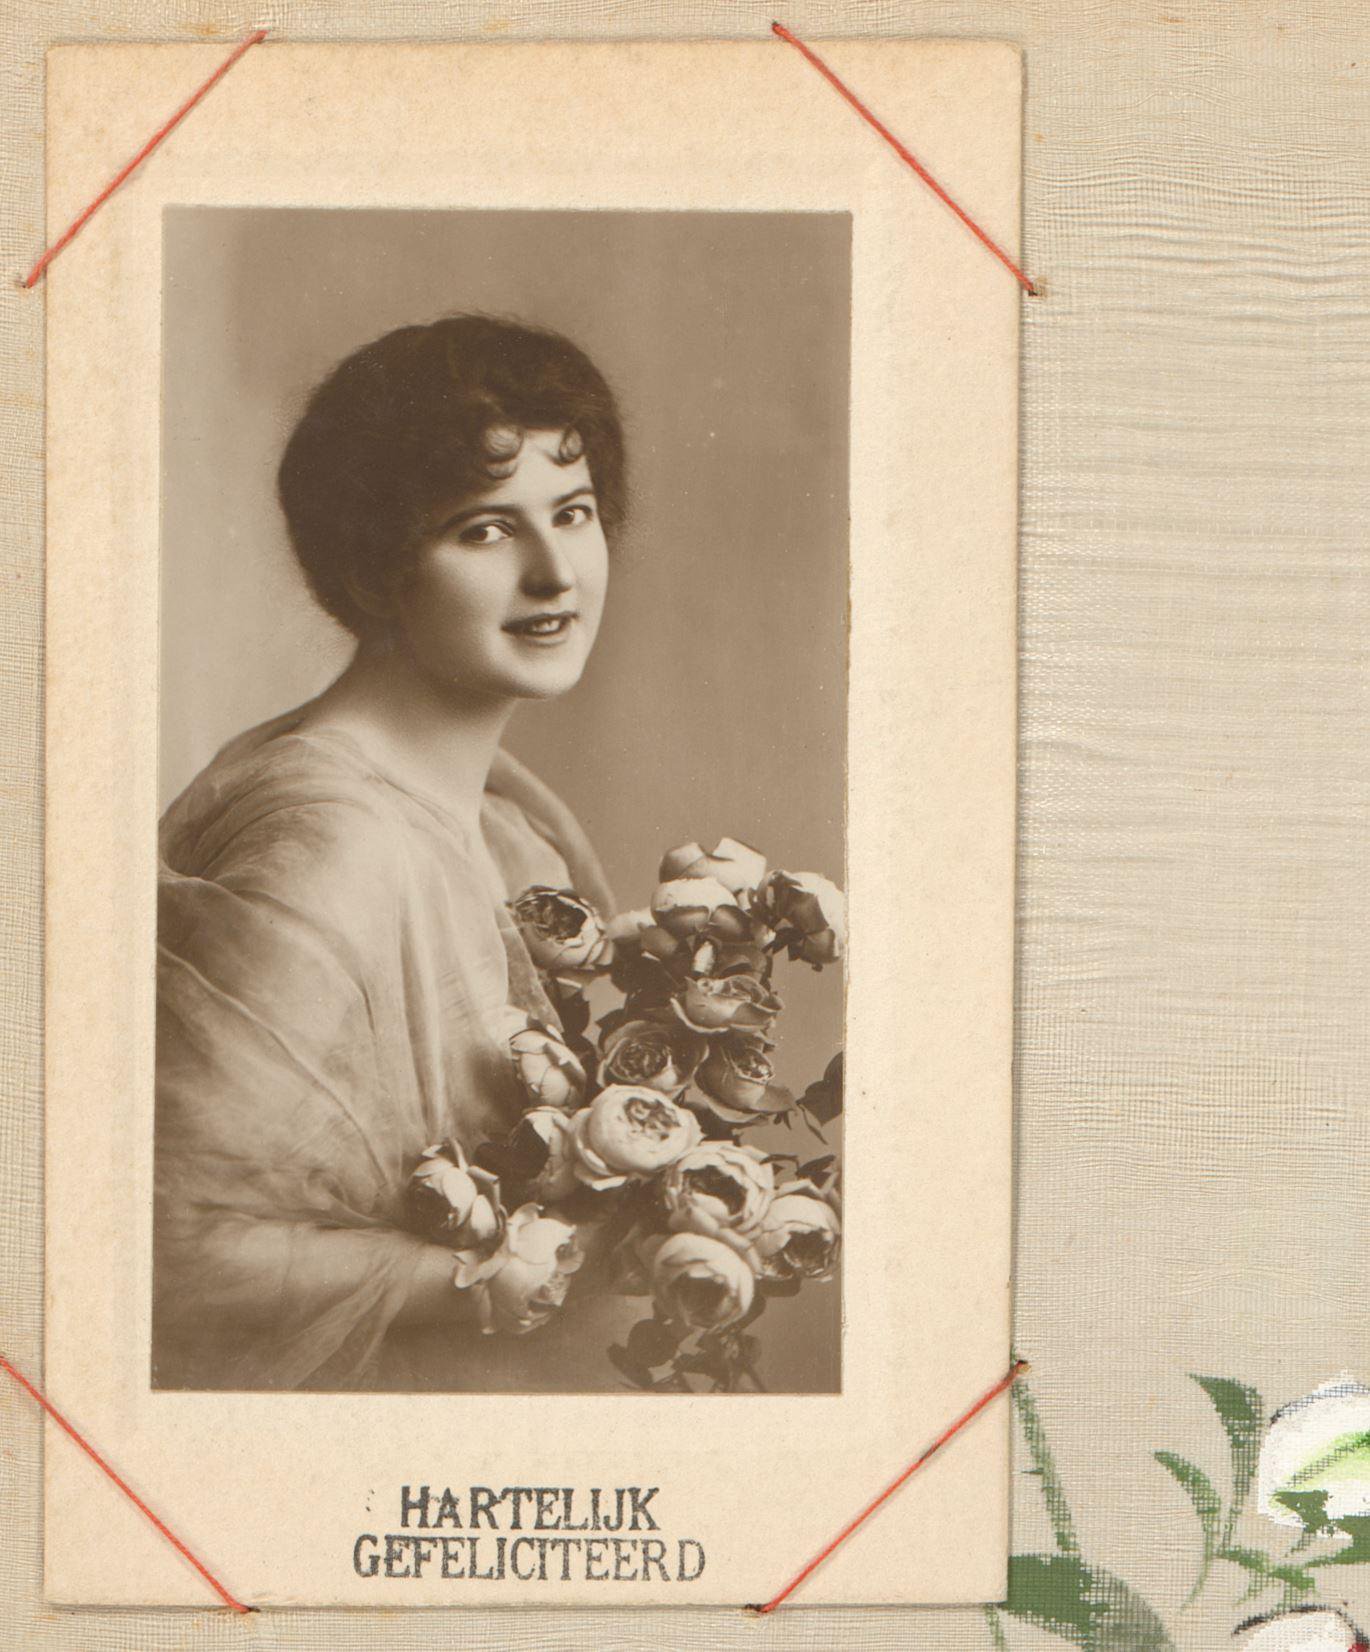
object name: album leaf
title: Portret van een vrouw met bloemen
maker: Anonymous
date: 1880-1920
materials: paint, photographic support, silk, textile, watercolor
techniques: brush, gelatin silver print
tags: flowers, adult woman, historical persons